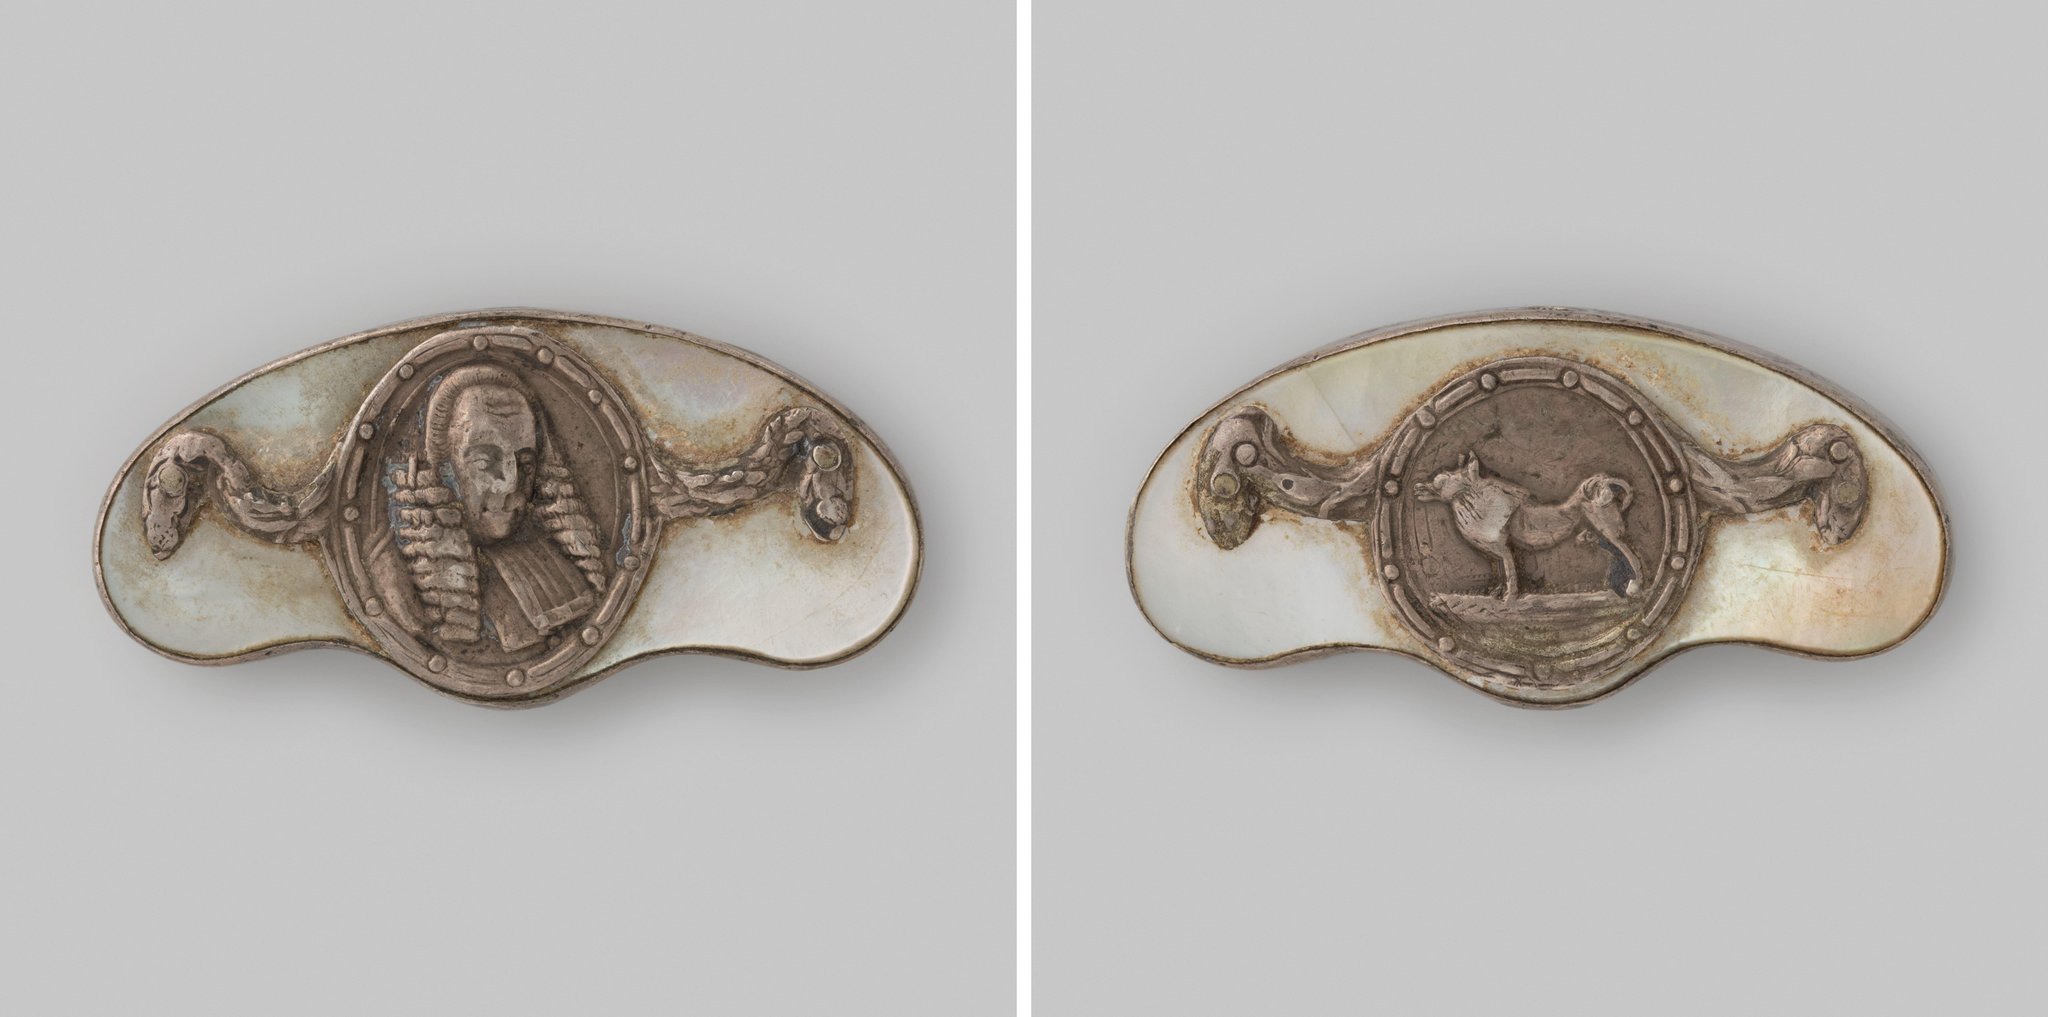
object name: handle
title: Hendrik Danielsz. Hooft, burgemeester van Amsterdam en de keeshond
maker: Anonymous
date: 1787-1794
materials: mother of pearl, silver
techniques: fastening, striking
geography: netherlands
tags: amsterdam, mayor, hendrik danielsz. hooft